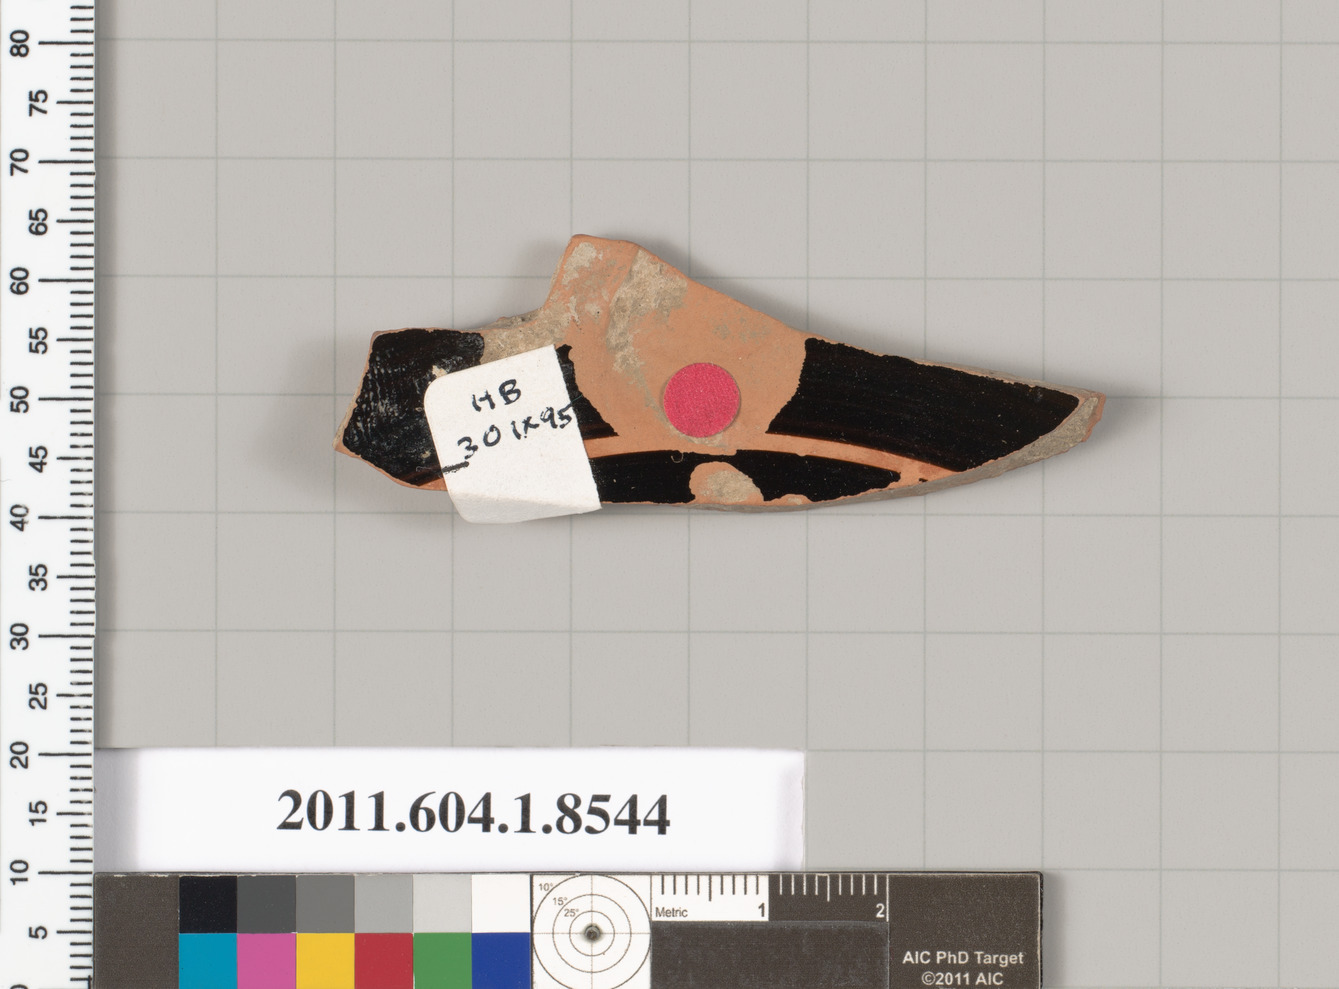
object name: kylix fragment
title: Terracotta fragment of a stemless kylix (drinking cup)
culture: greek, attic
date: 460-450 BCE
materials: terracotta